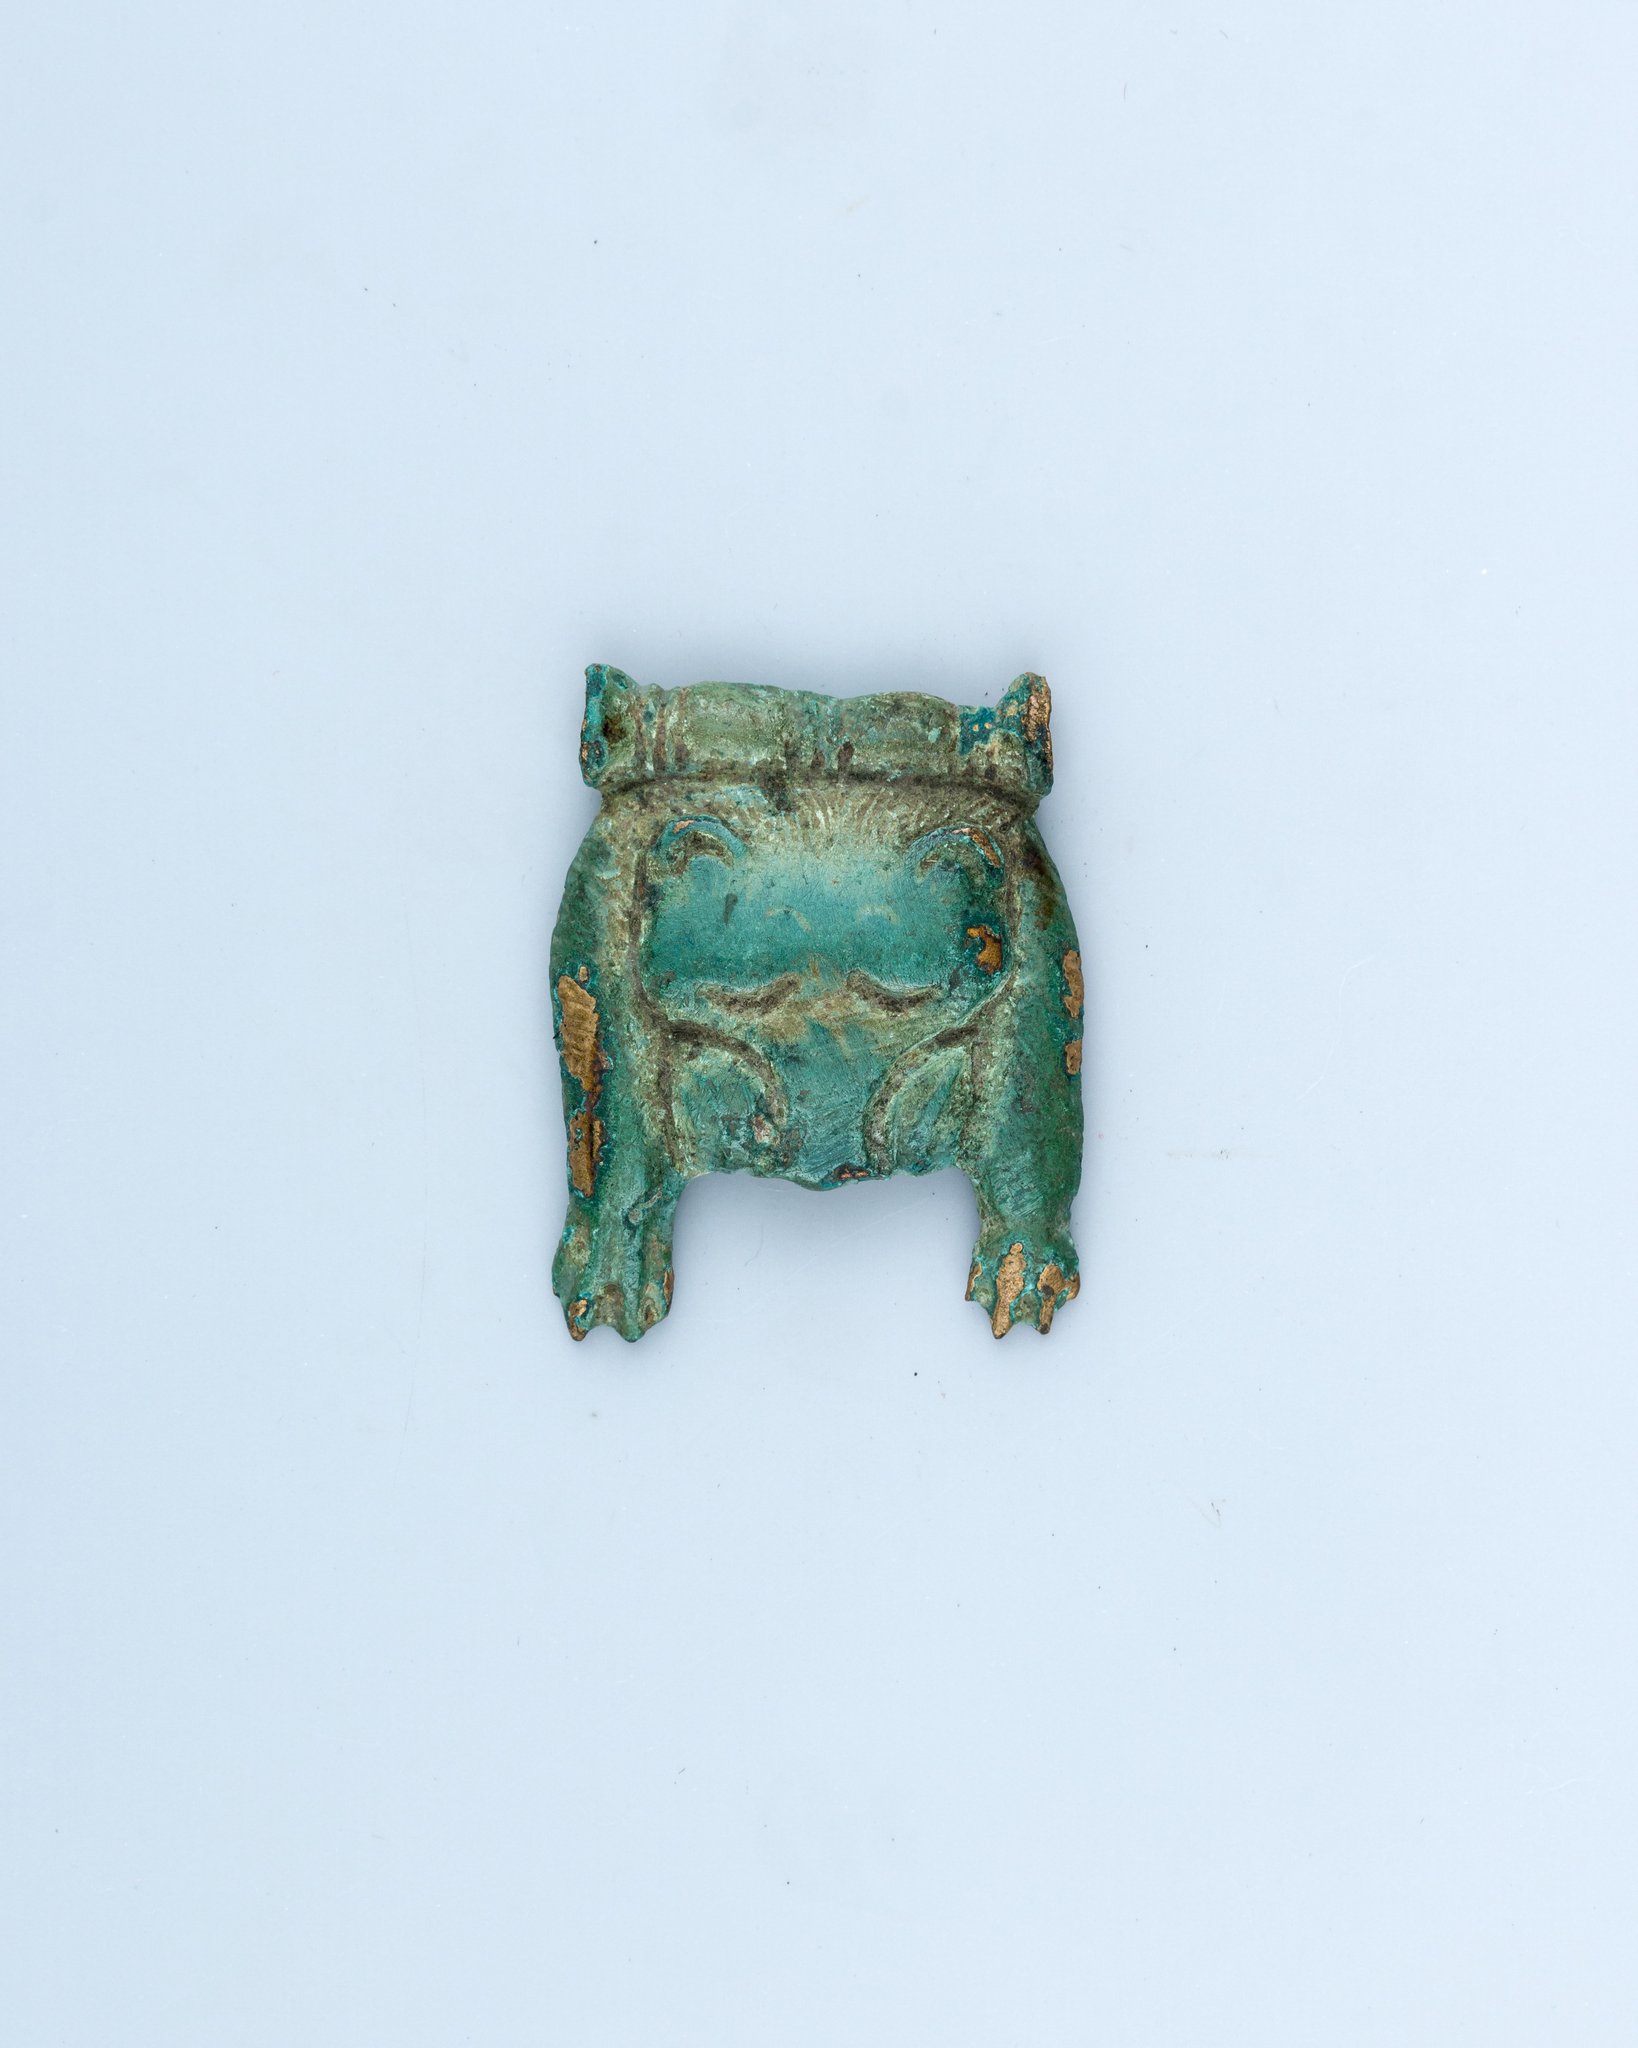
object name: part of buckle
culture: european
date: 1401-1700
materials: brass, gilt, gold